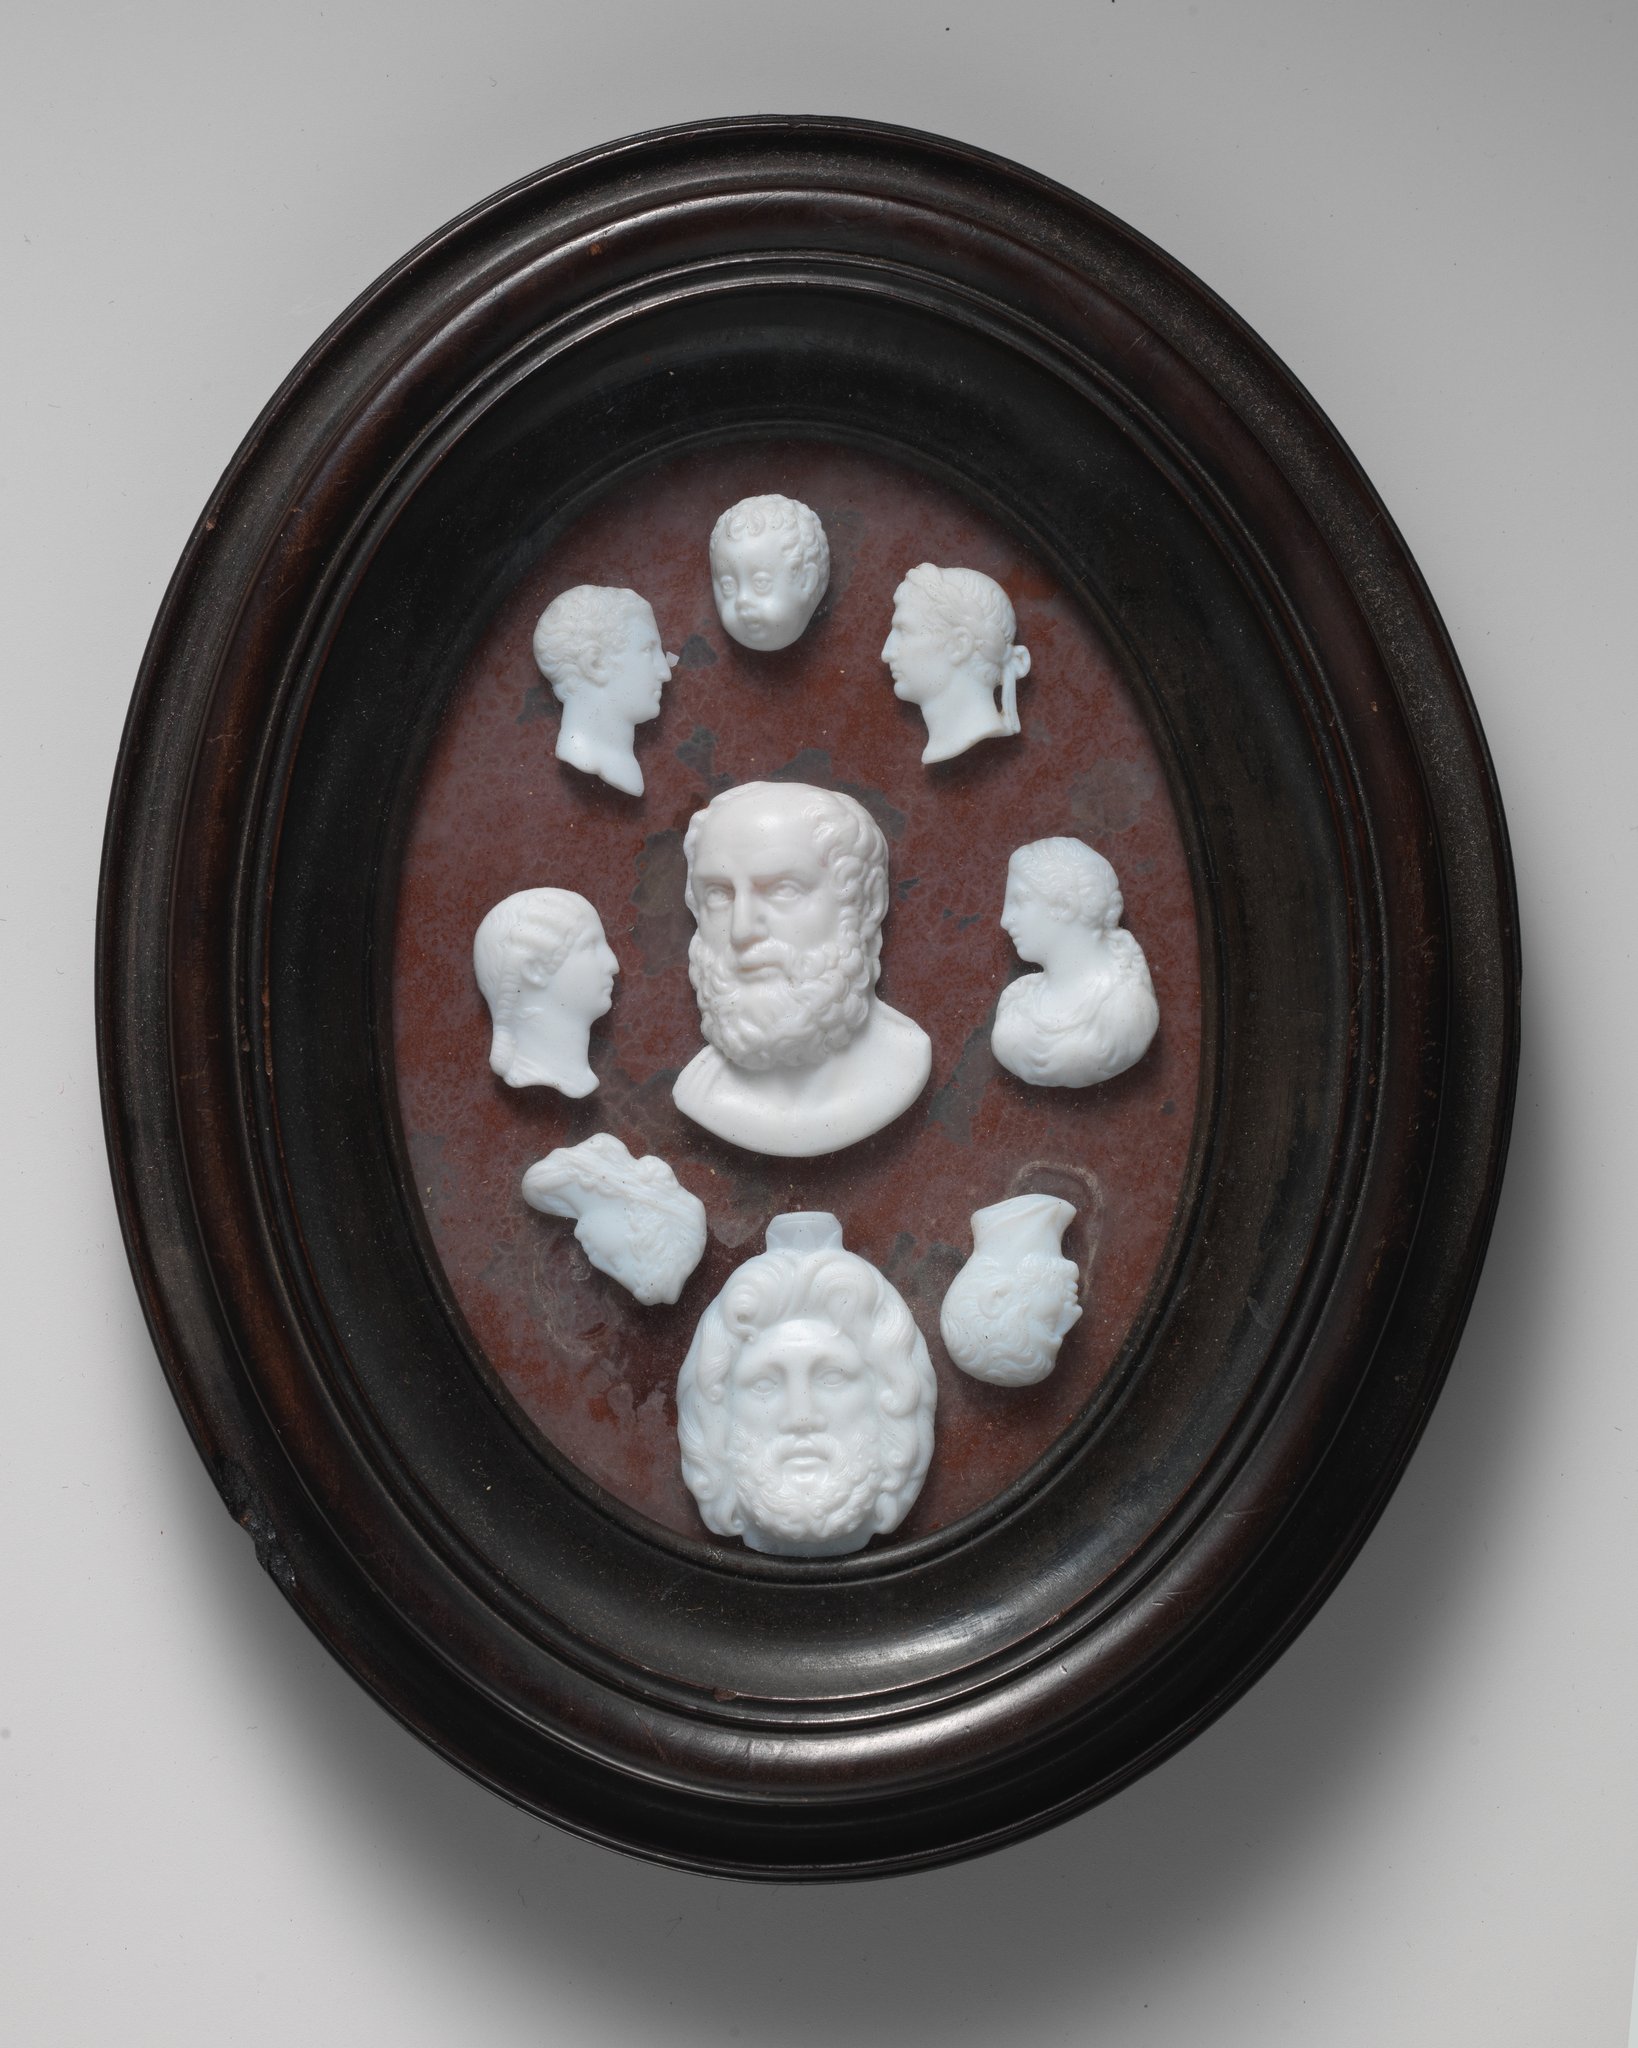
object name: cast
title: Casts from antique gems (9)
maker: james tassie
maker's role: artist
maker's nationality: british, scottish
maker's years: 1735-1799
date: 1767-1800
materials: glass, paste, wood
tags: heads,men,profiles,women